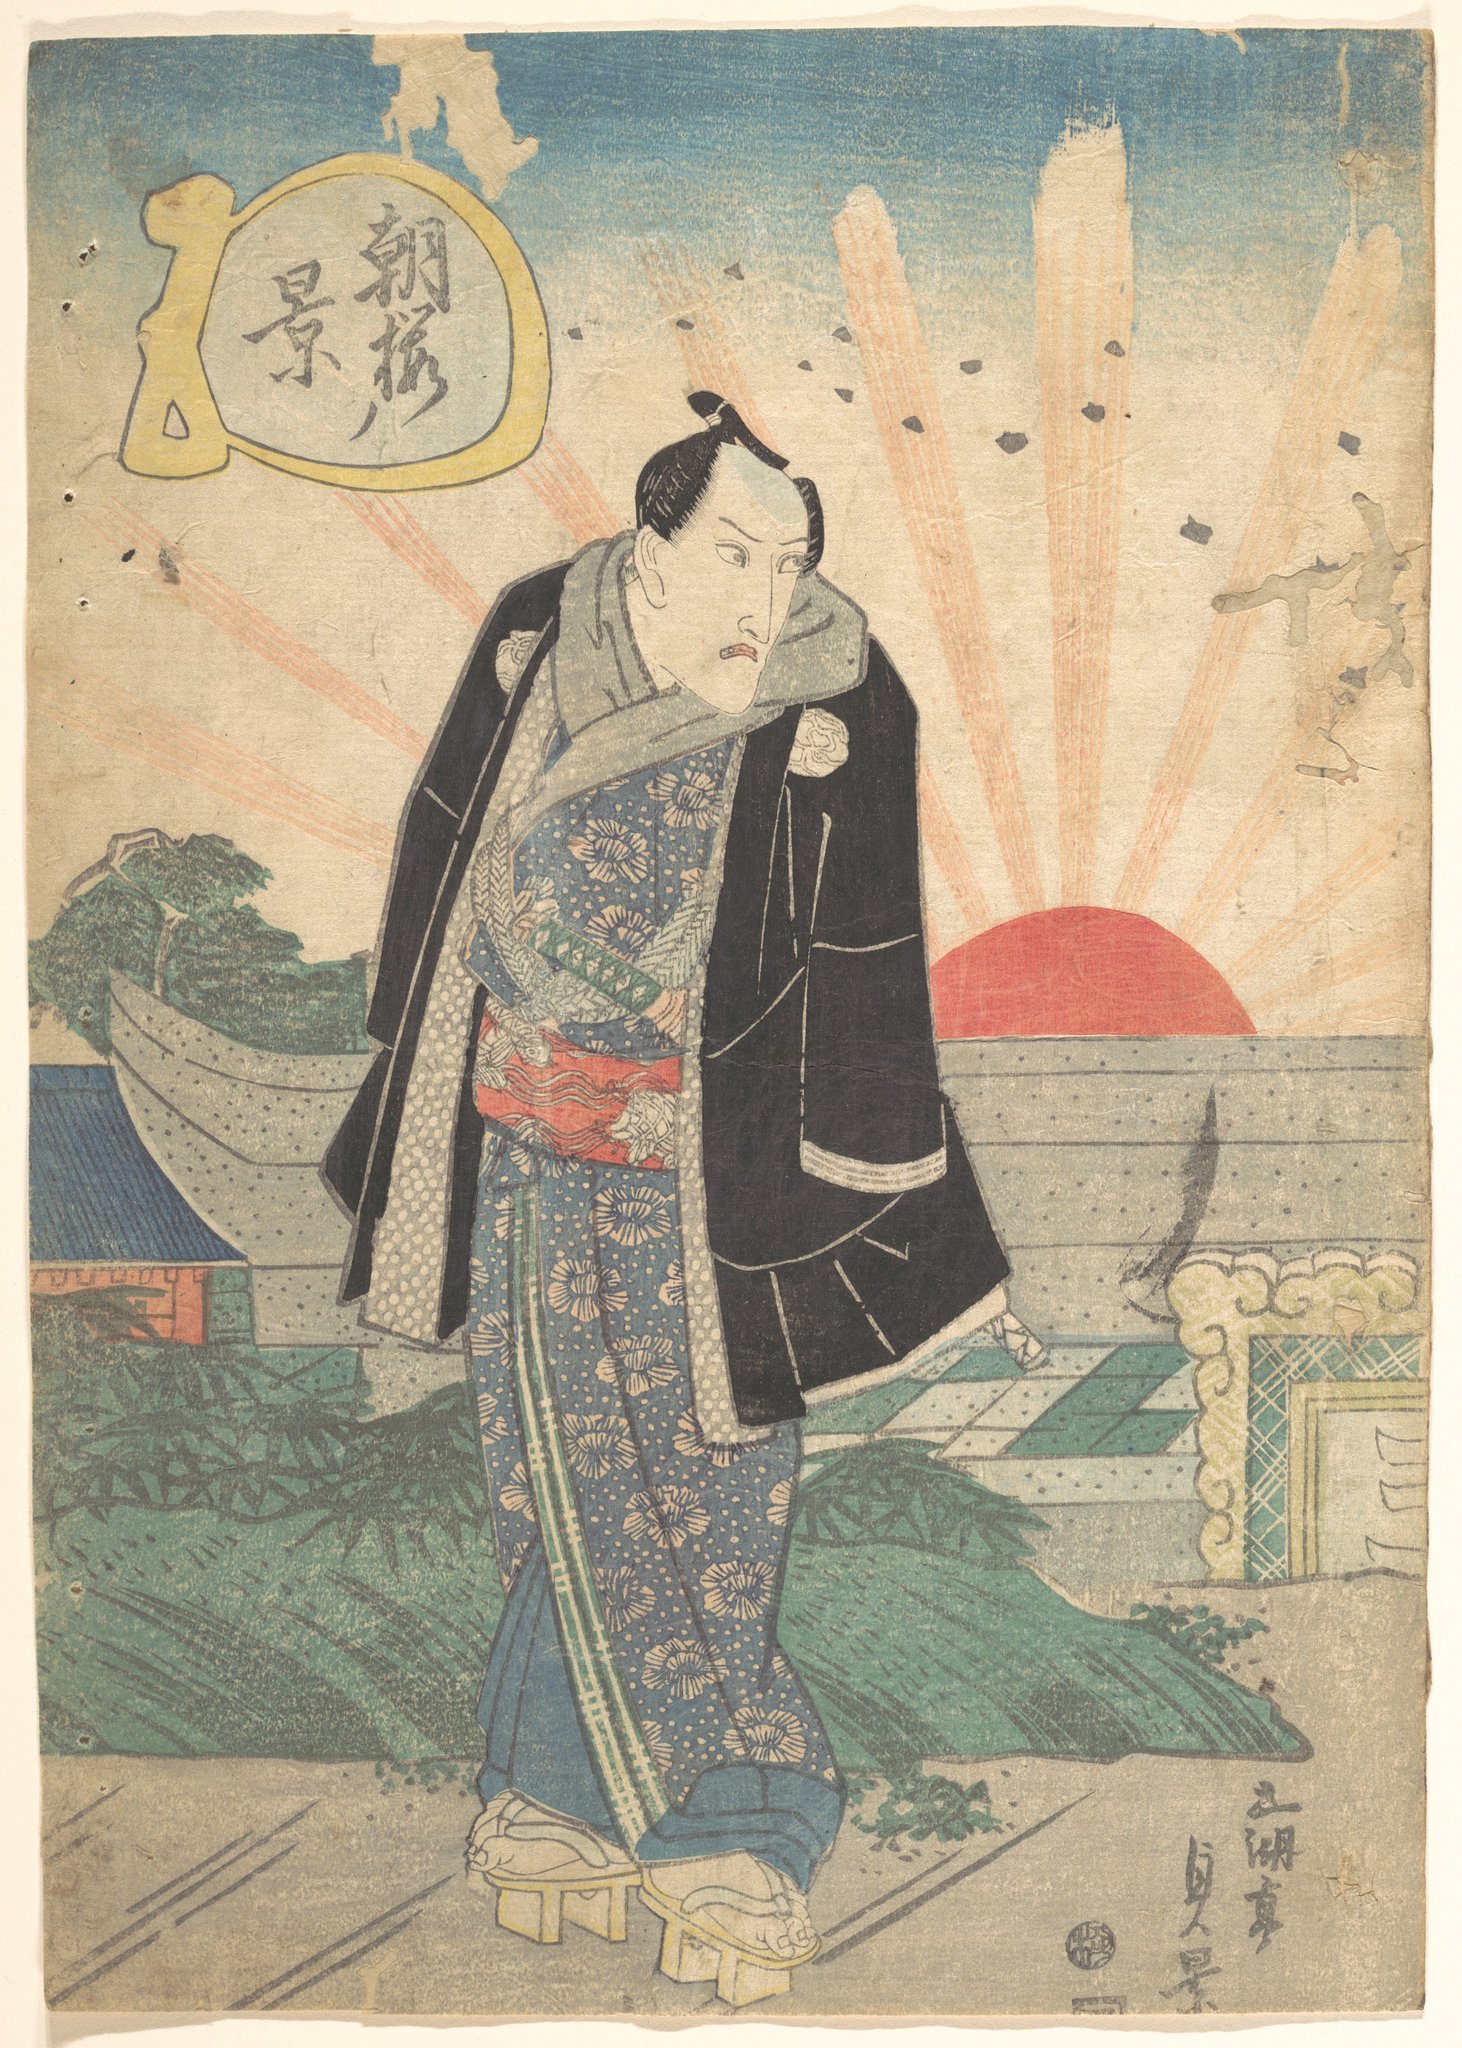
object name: print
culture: japanese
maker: utagawa sadakage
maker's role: artist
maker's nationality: japanese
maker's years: 1800-1899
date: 1801-1900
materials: ink, paper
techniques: woodblock print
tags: men,sun